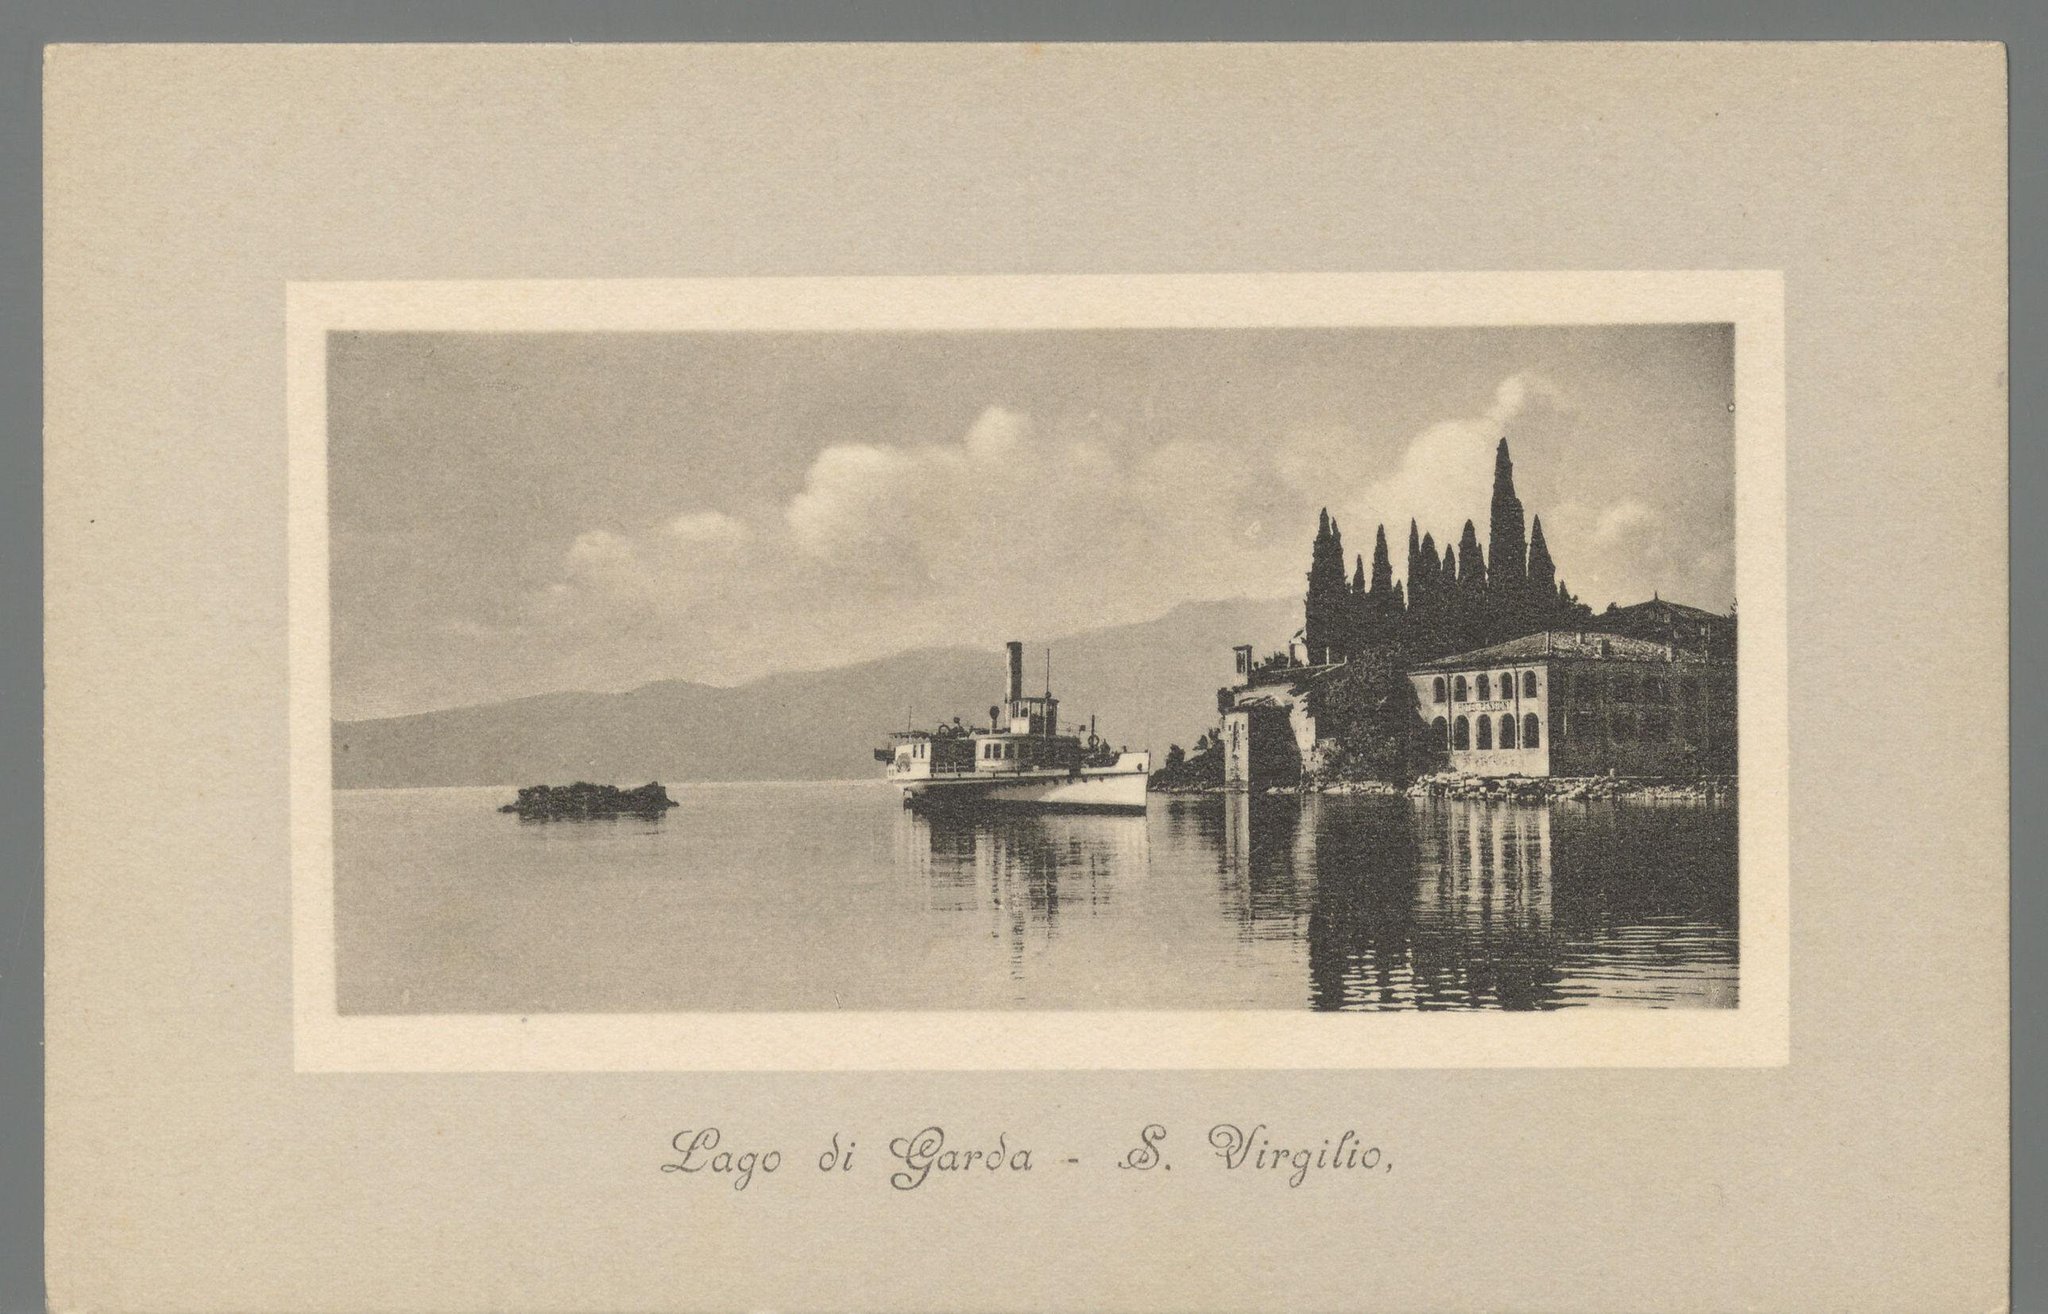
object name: ansichtkaart, prentbriefkaart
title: Lago di Garda. S. Virgilio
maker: Anonymous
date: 1905-1930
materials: cardboard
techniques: photograph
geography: como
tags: ships (in general), lake